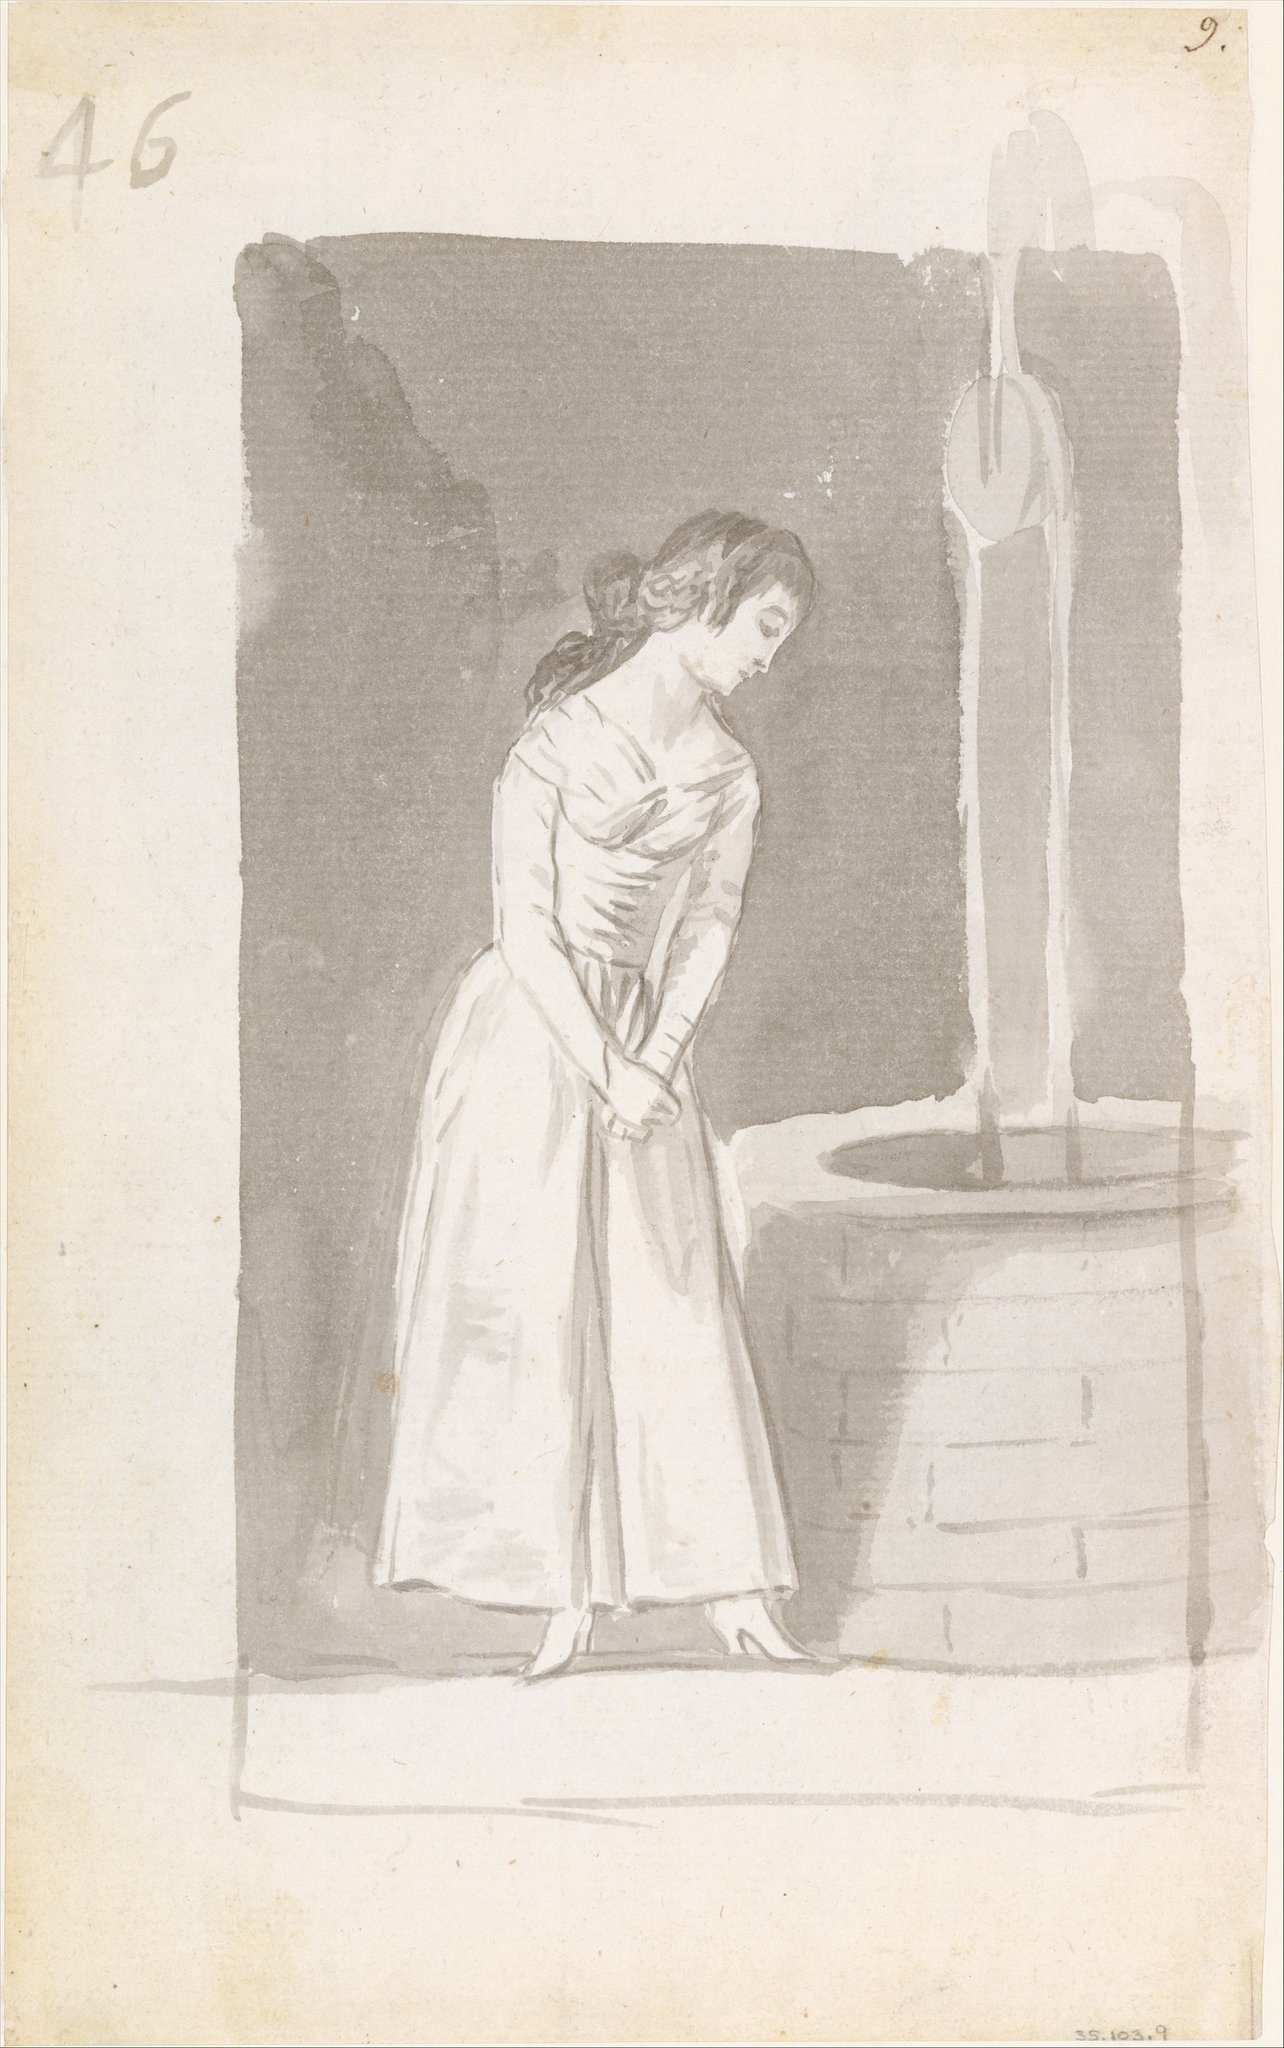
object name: drawing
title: A young woman looking into a well; folio 46 (verso) from the Madrid Album "B"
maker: goya (francisco de goya y lucientes)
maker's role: artist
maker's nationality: spanish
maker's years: 1746-1828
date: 1795-1797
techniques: brush, wash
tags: wells,women